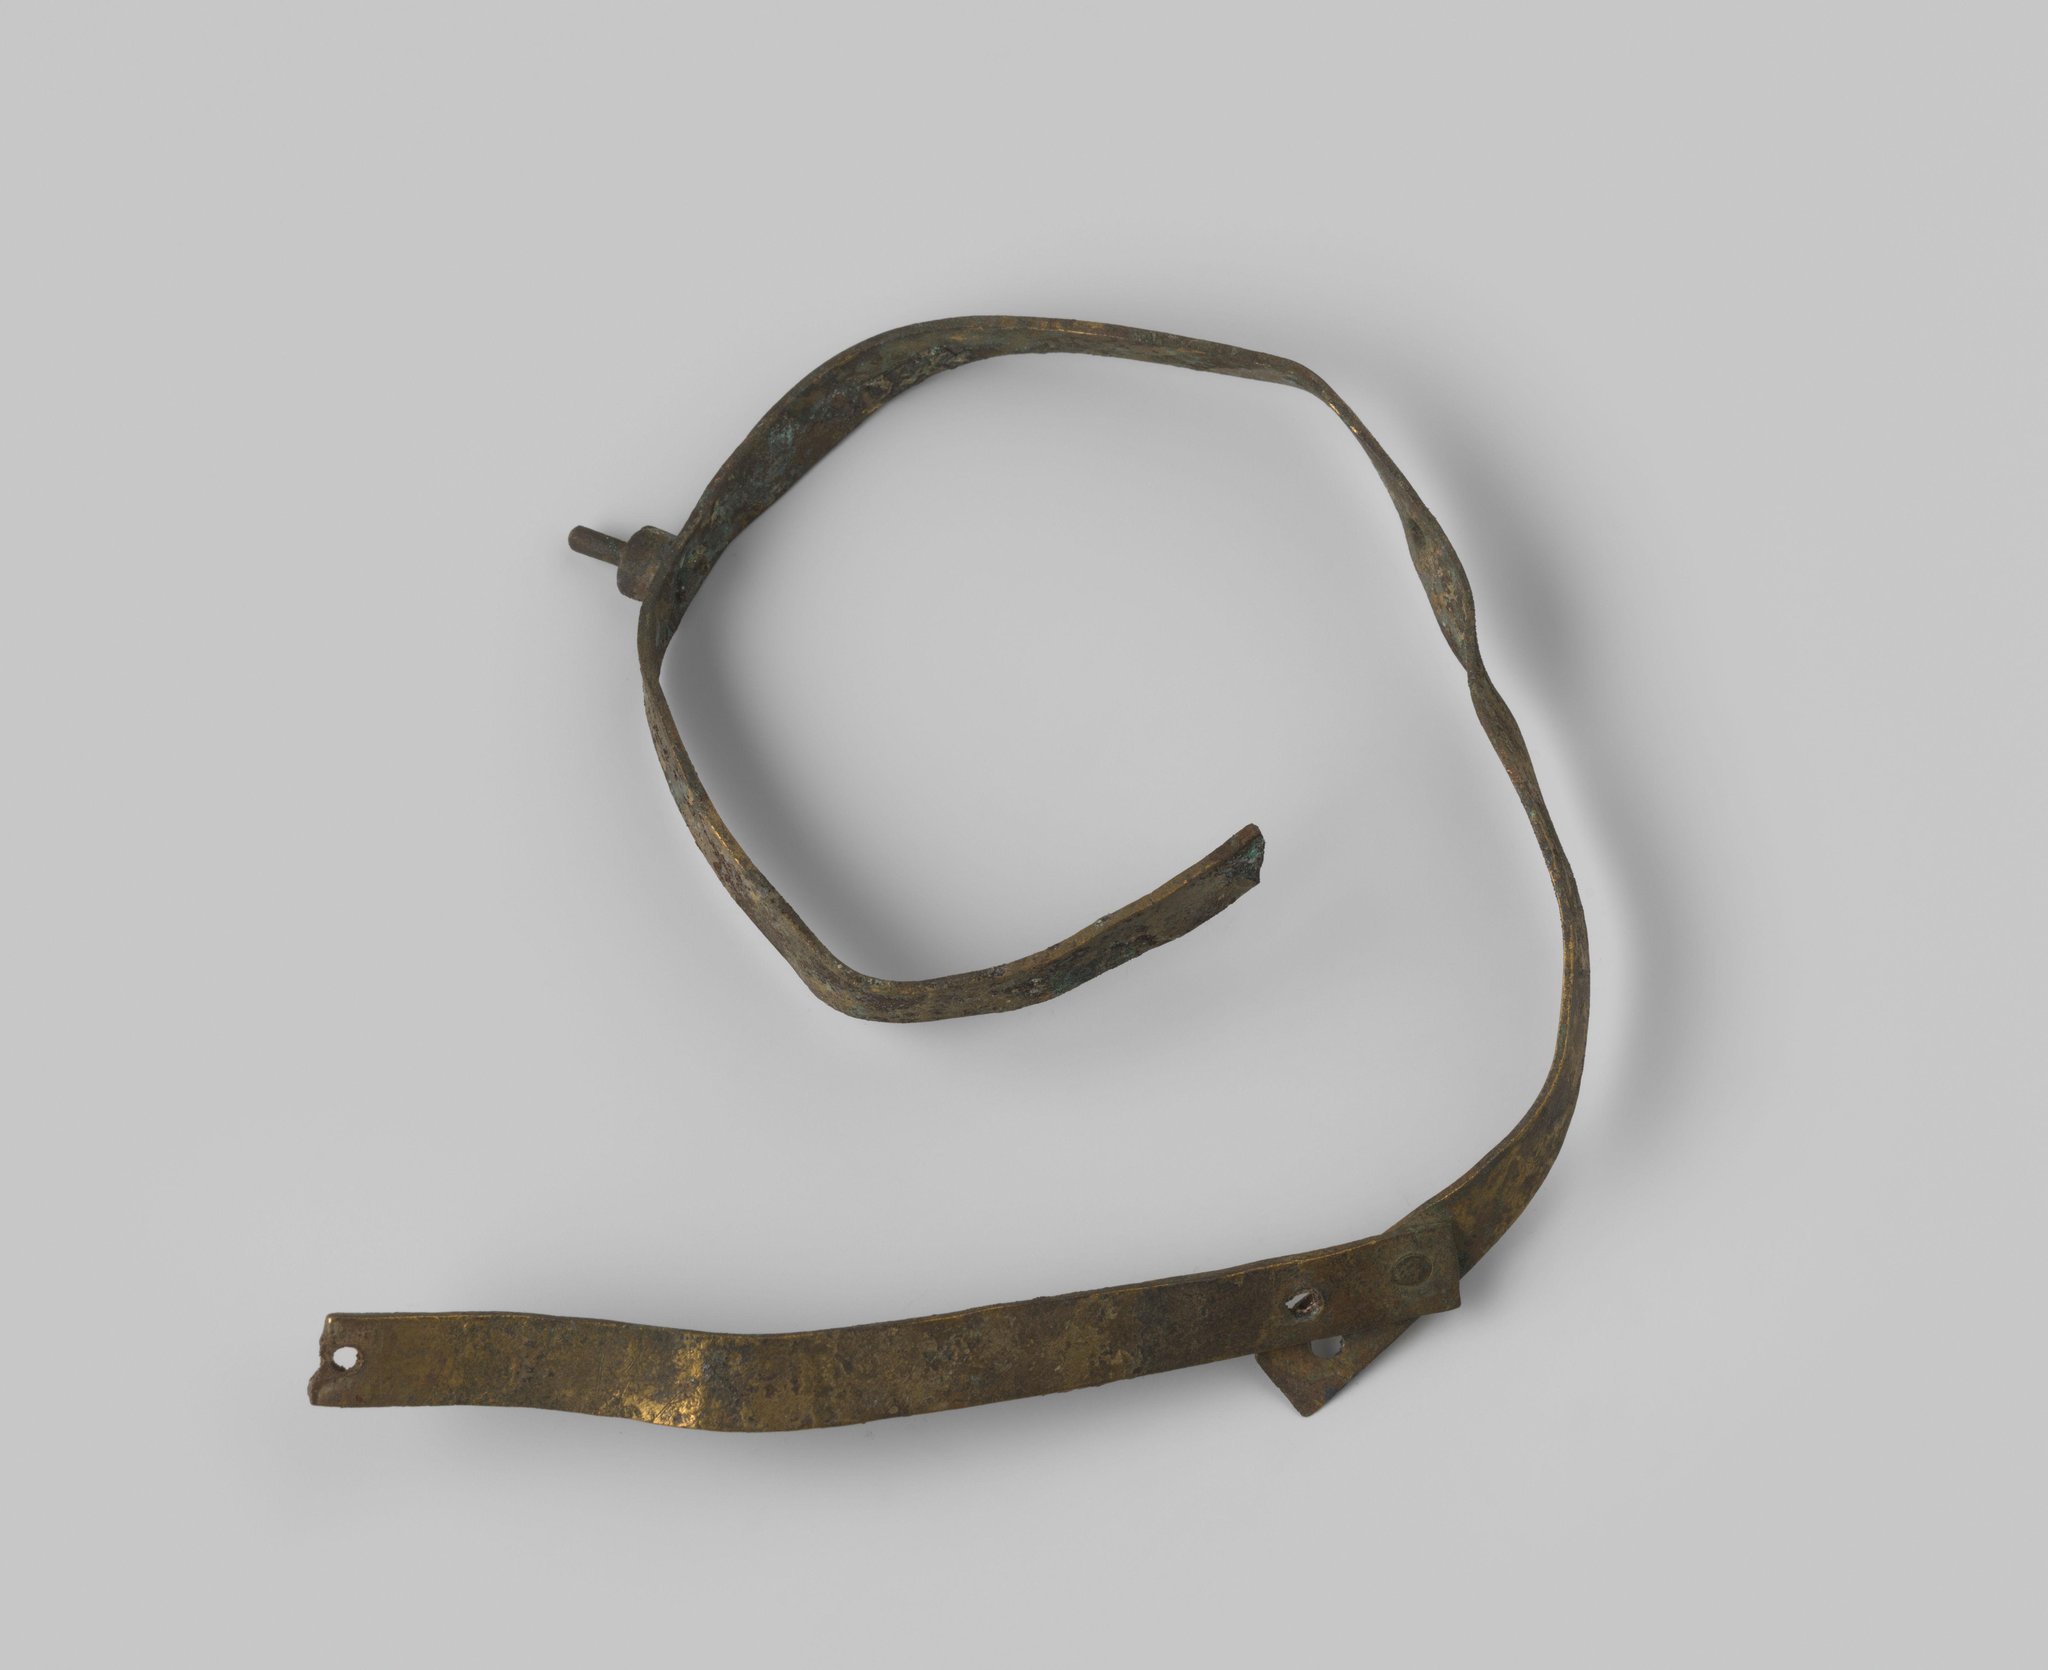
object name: hook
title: Ophanghaak voor een lamp uit het wrak van de Oost-Indiëvaarder Hollandia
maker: Anonymous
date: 1700-1743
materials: copper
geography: netherlands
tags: verenigde oostindische compagnie, hollandia (schip), annet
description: Suspension lamp, gimbalring; fragm, 2 riveted strips, bent, ends broken, with small lateral riveted pin.